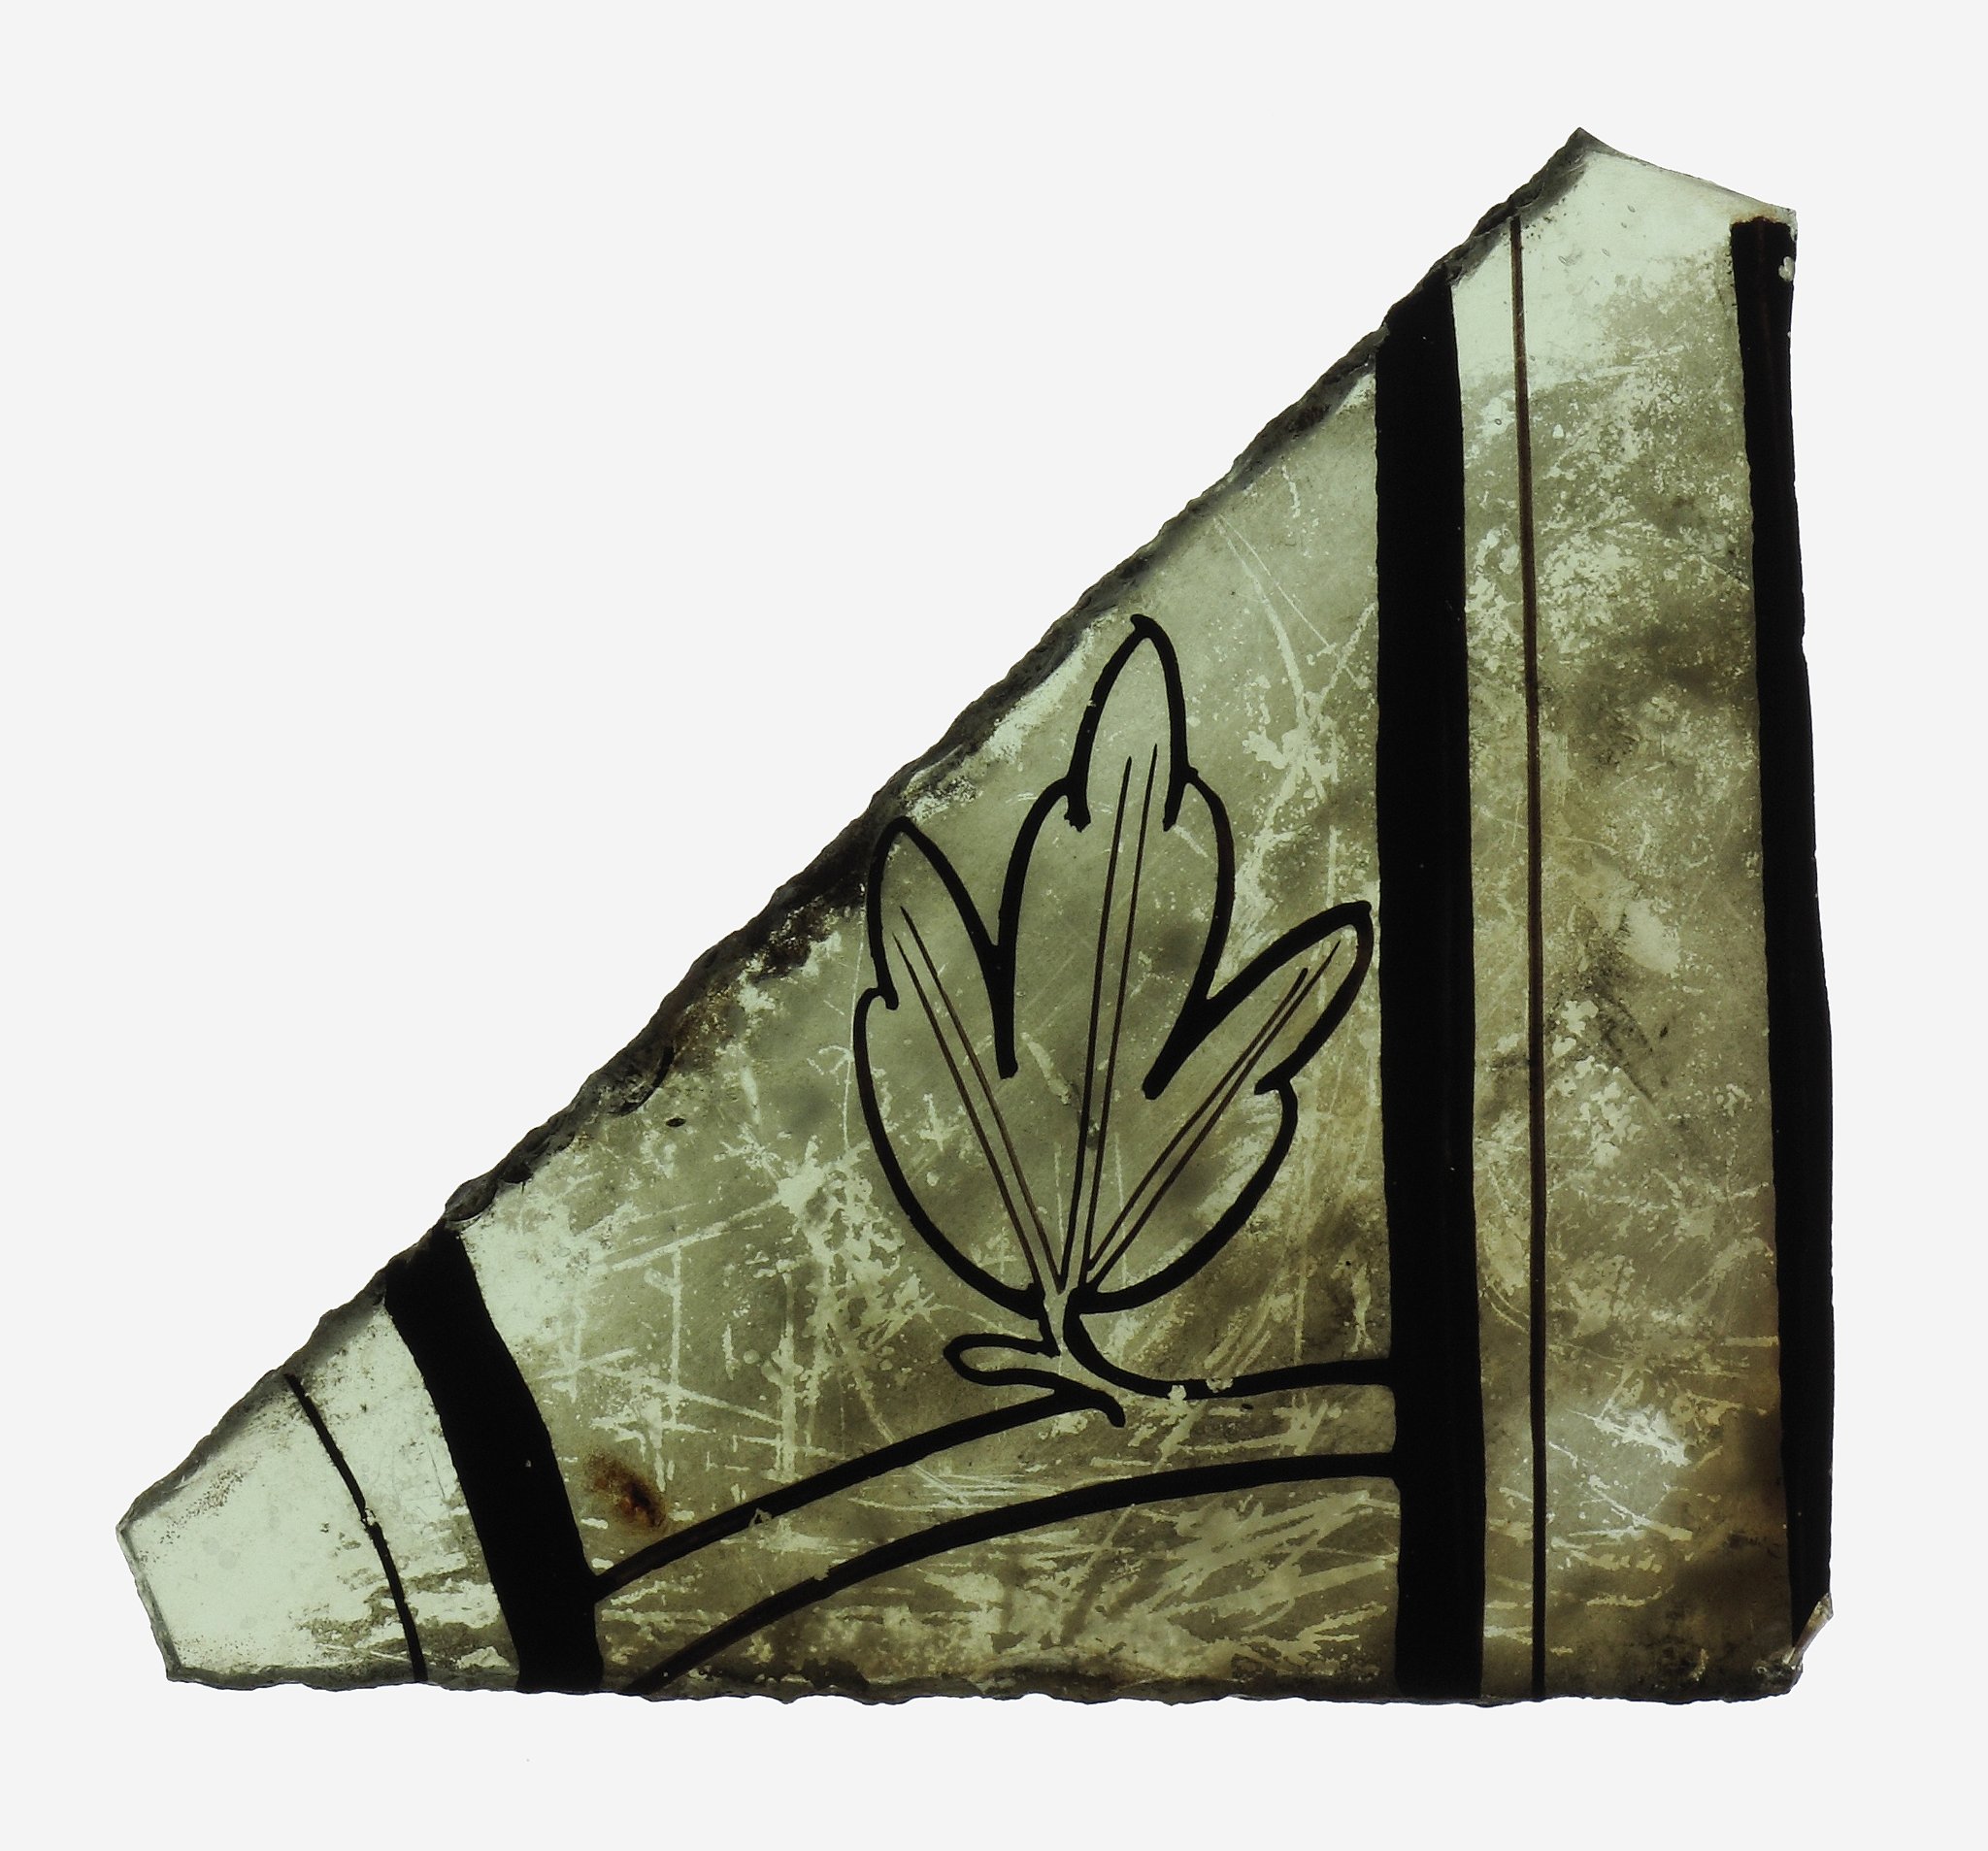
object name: fragment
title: Glass Fragment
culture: french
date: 1301-1400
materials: glass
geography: france